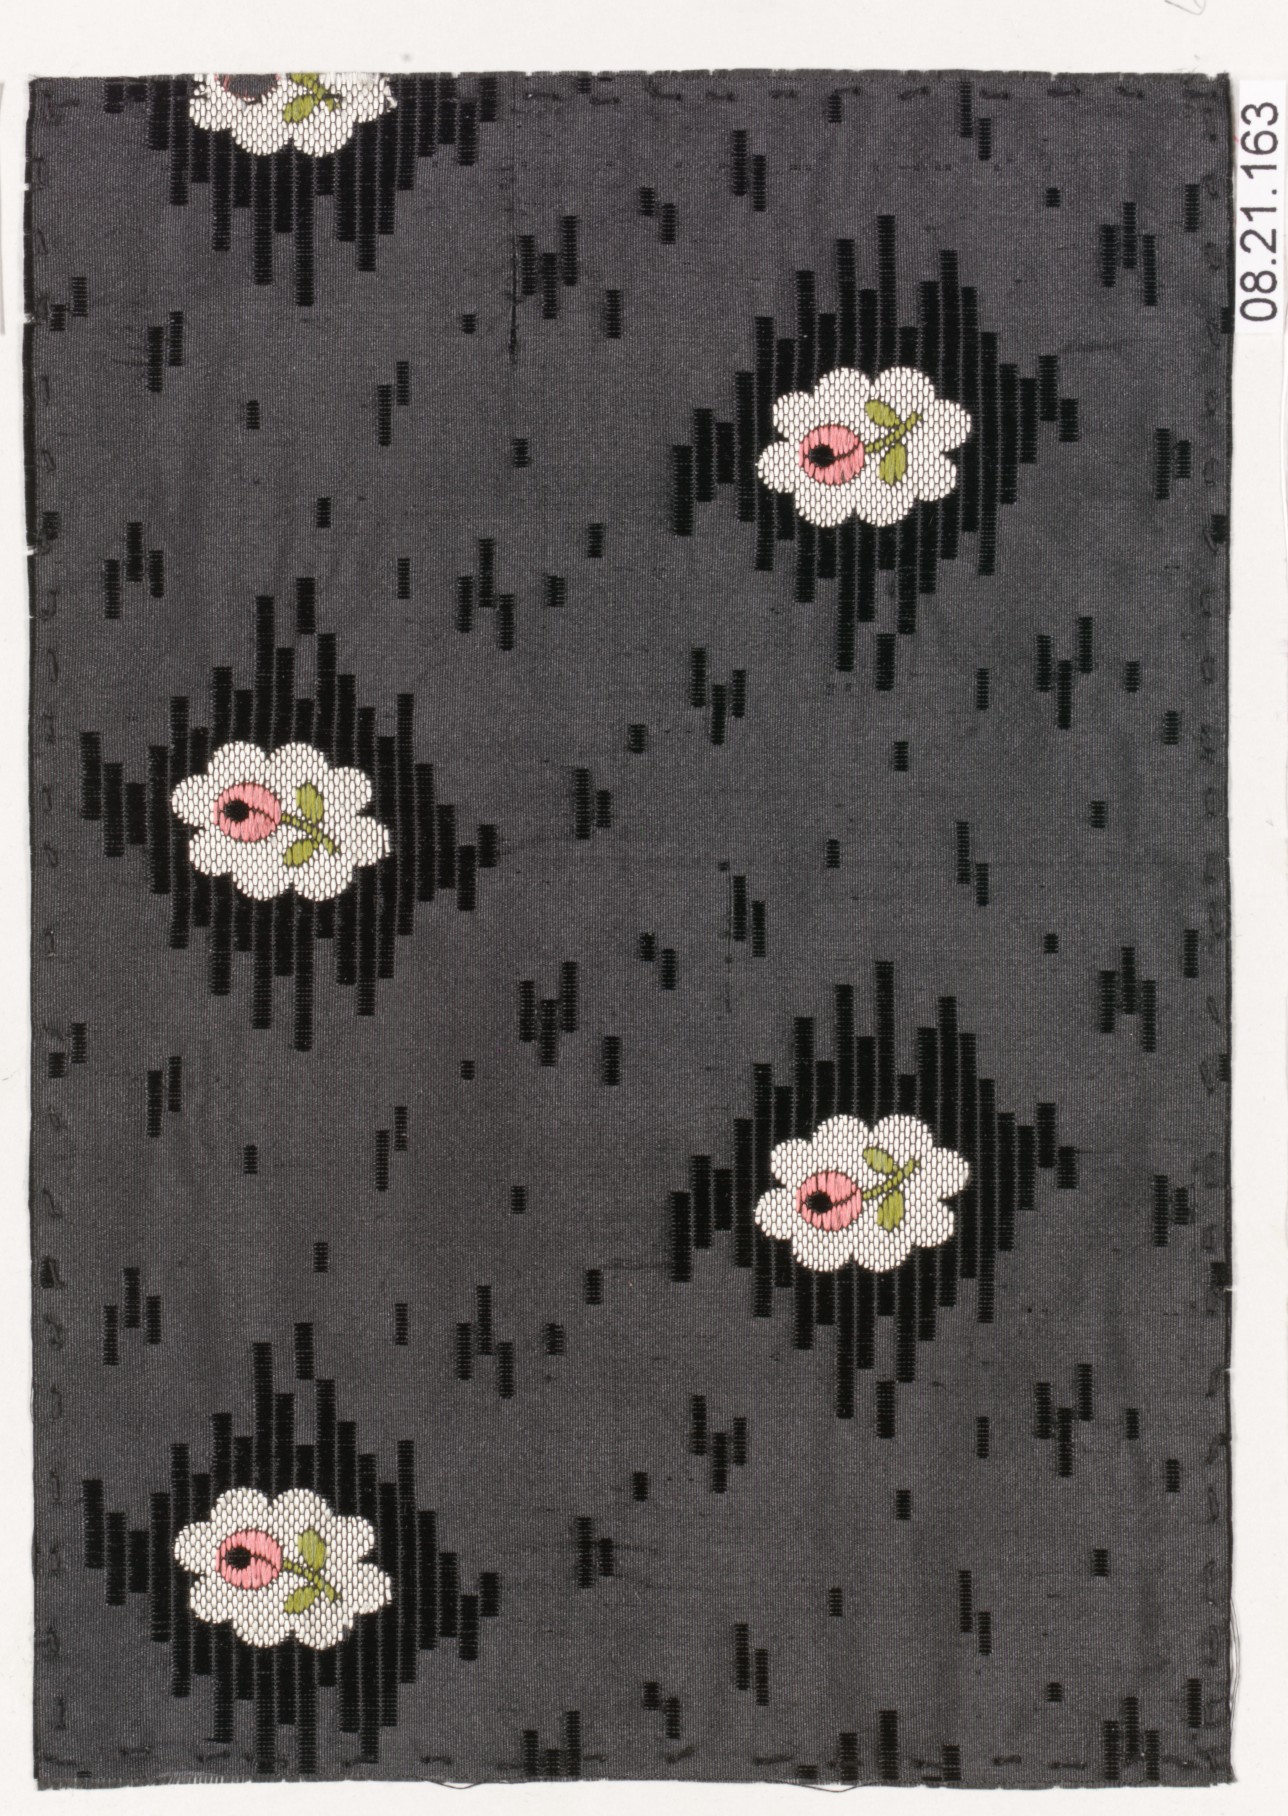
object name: textile sample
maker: Anonymous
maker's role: designer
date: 1900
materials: silk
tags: flowers